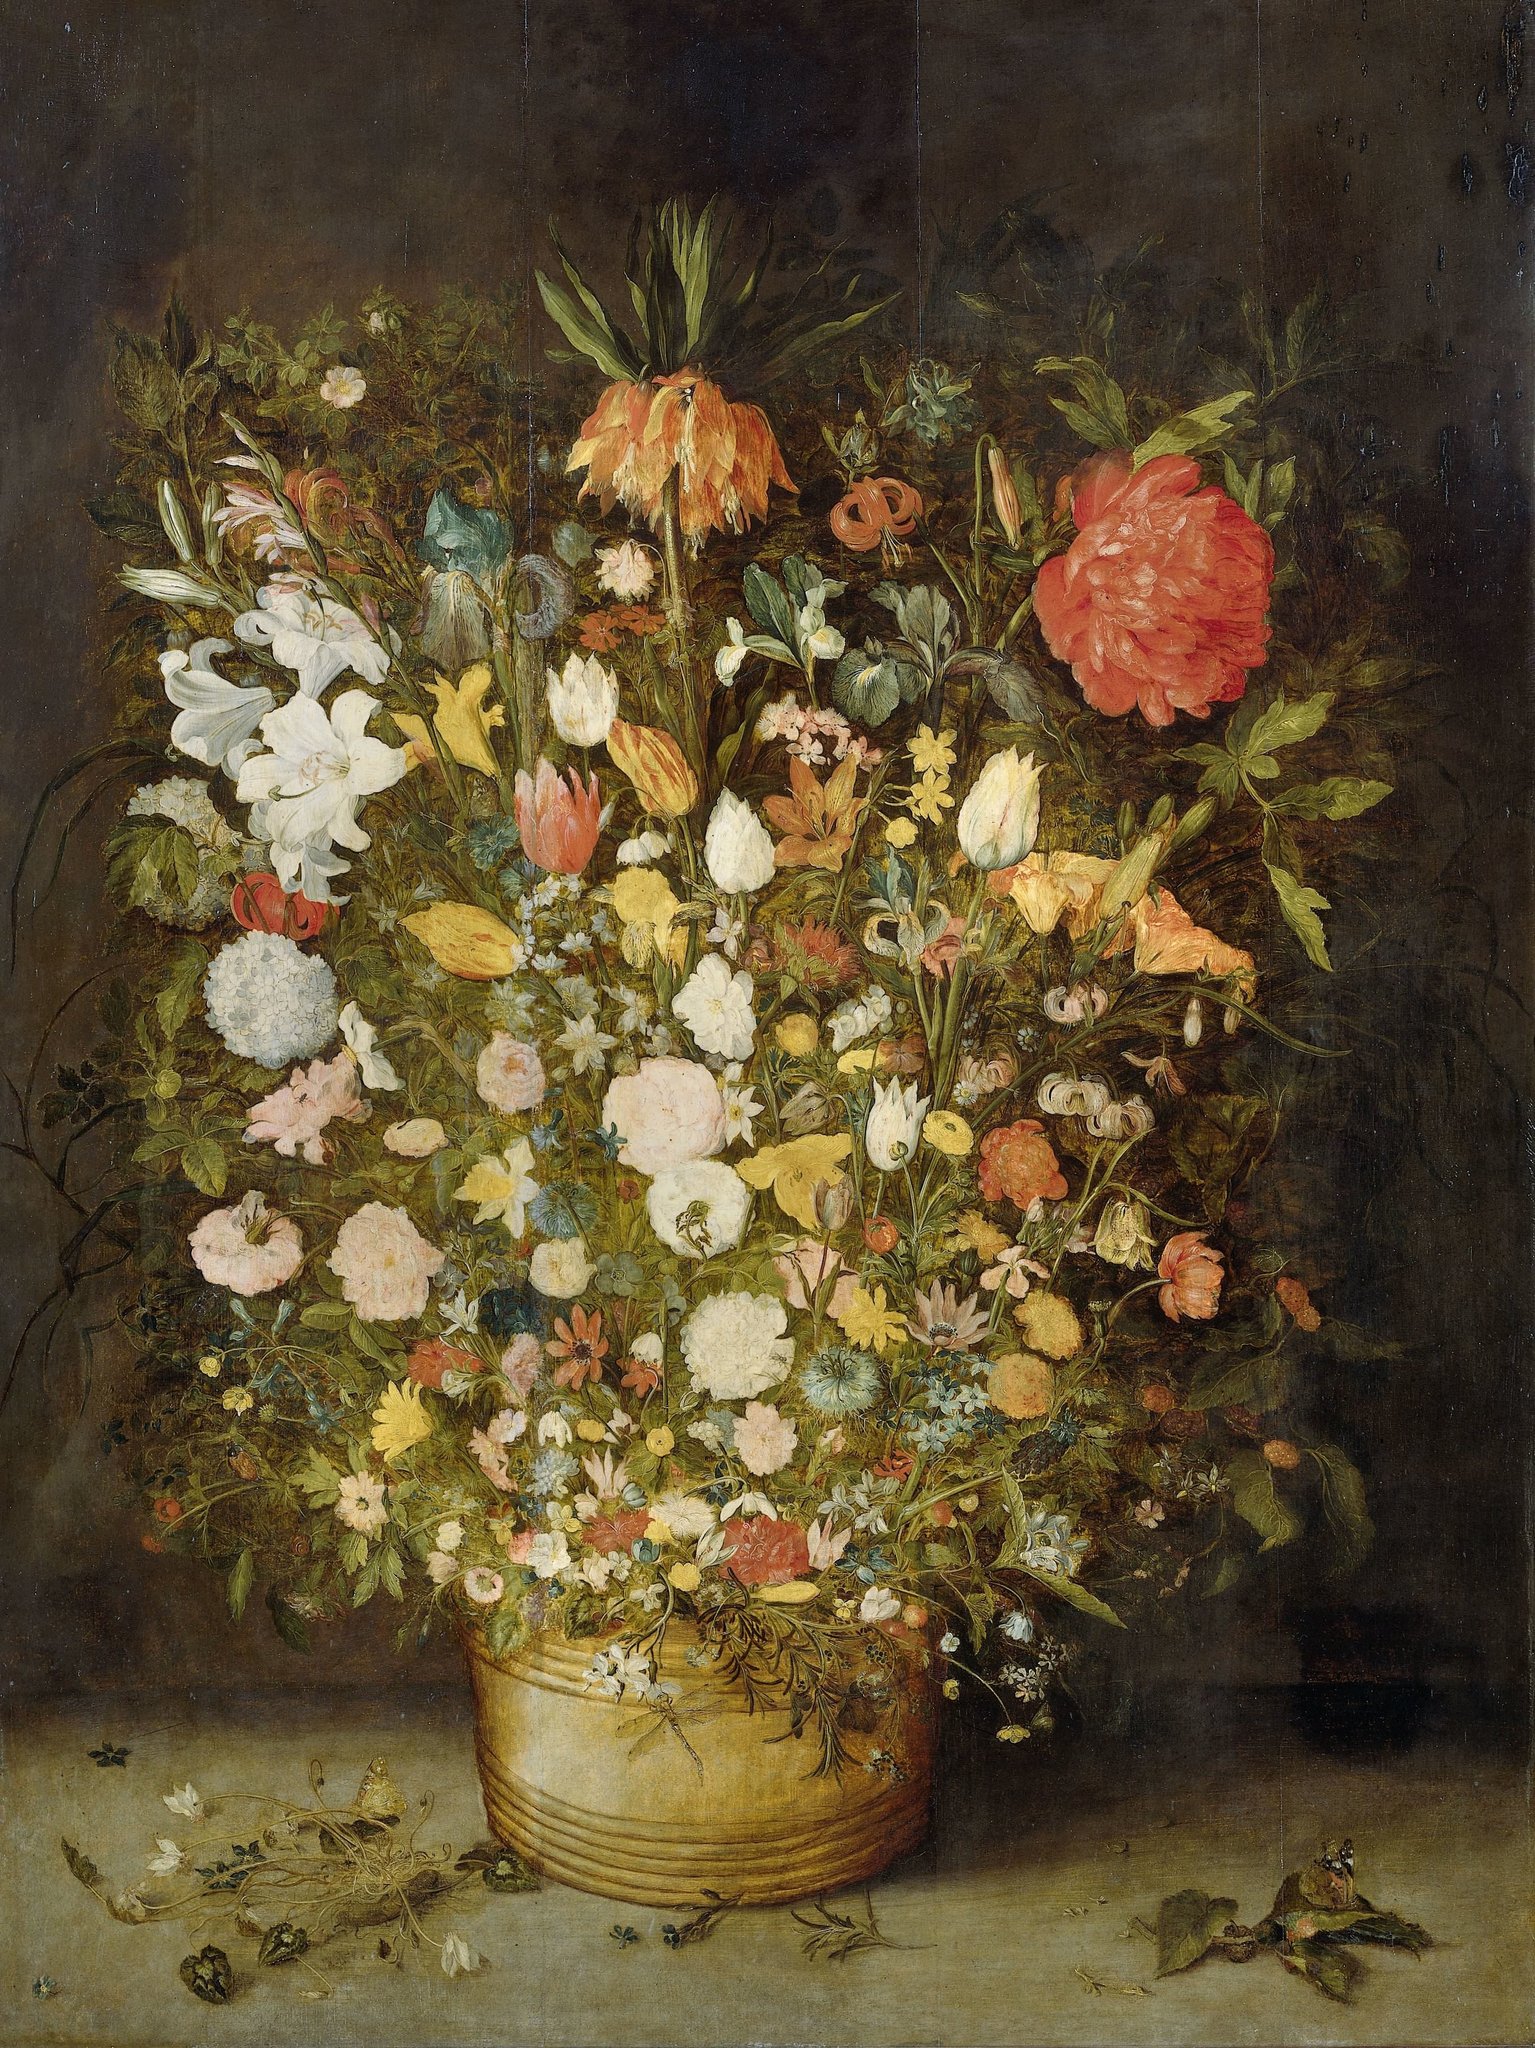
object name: painting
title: Still Life with Flowers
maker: jan brueghel (i)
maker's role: draughtsman, painter, print maker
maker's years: 1568-1625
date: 1600-1630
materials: oil, panel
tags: flowers in a vase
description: Studio of Jan Brueghel I (1568 - 1625). Still life with flowers. Gift of Mr and Mrs Kessler -Hülsmann, 1940.